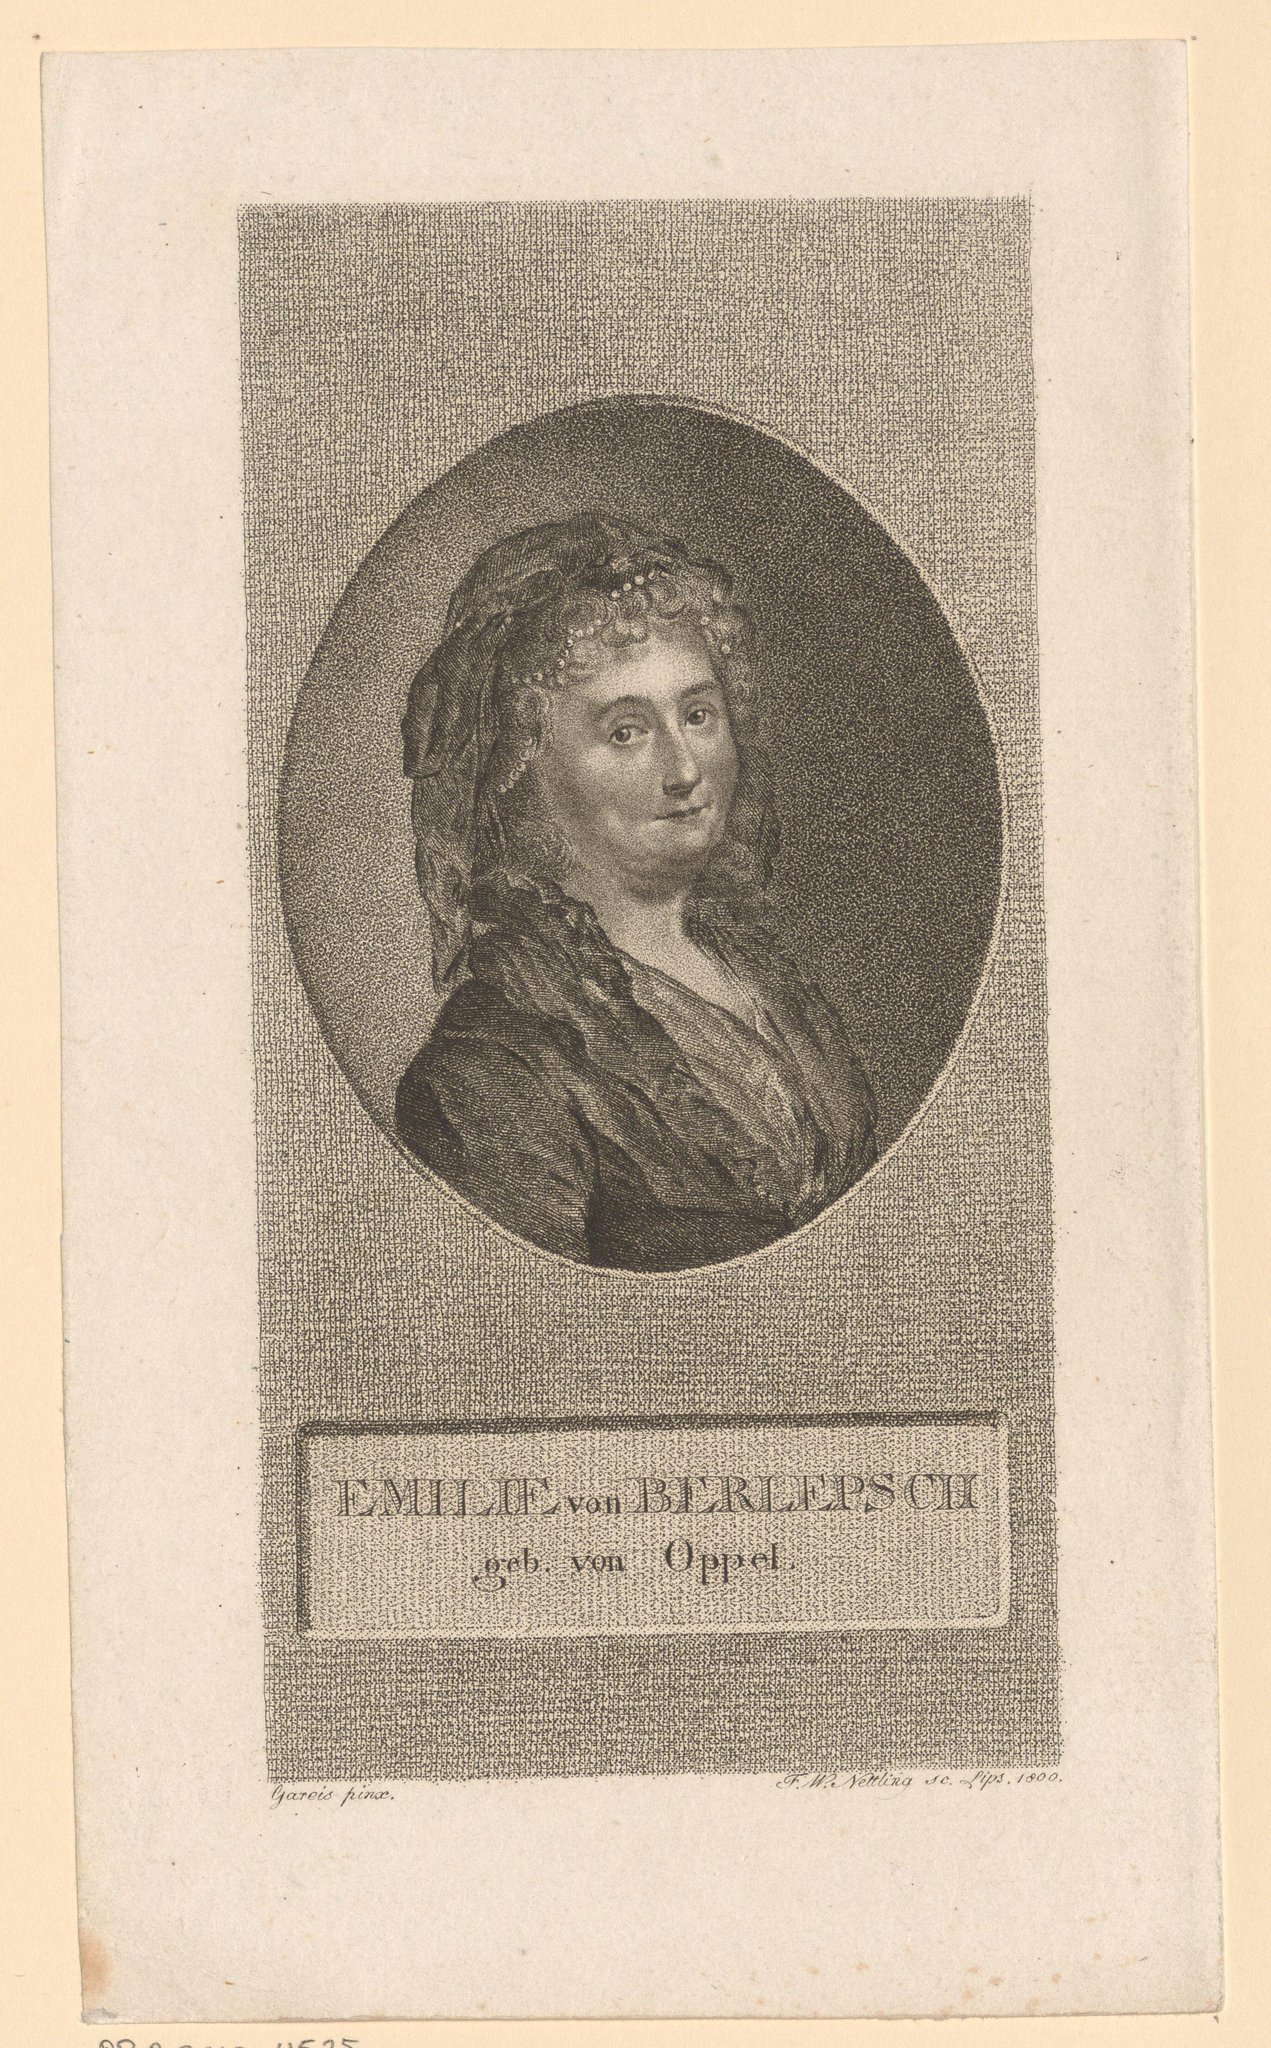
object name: print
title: Portret van Emilie von Berlepsch-Oppel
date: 1800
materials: paper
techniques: etching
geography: leipzig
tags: historical persons - bb - woman, portrait of a writer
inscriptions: date